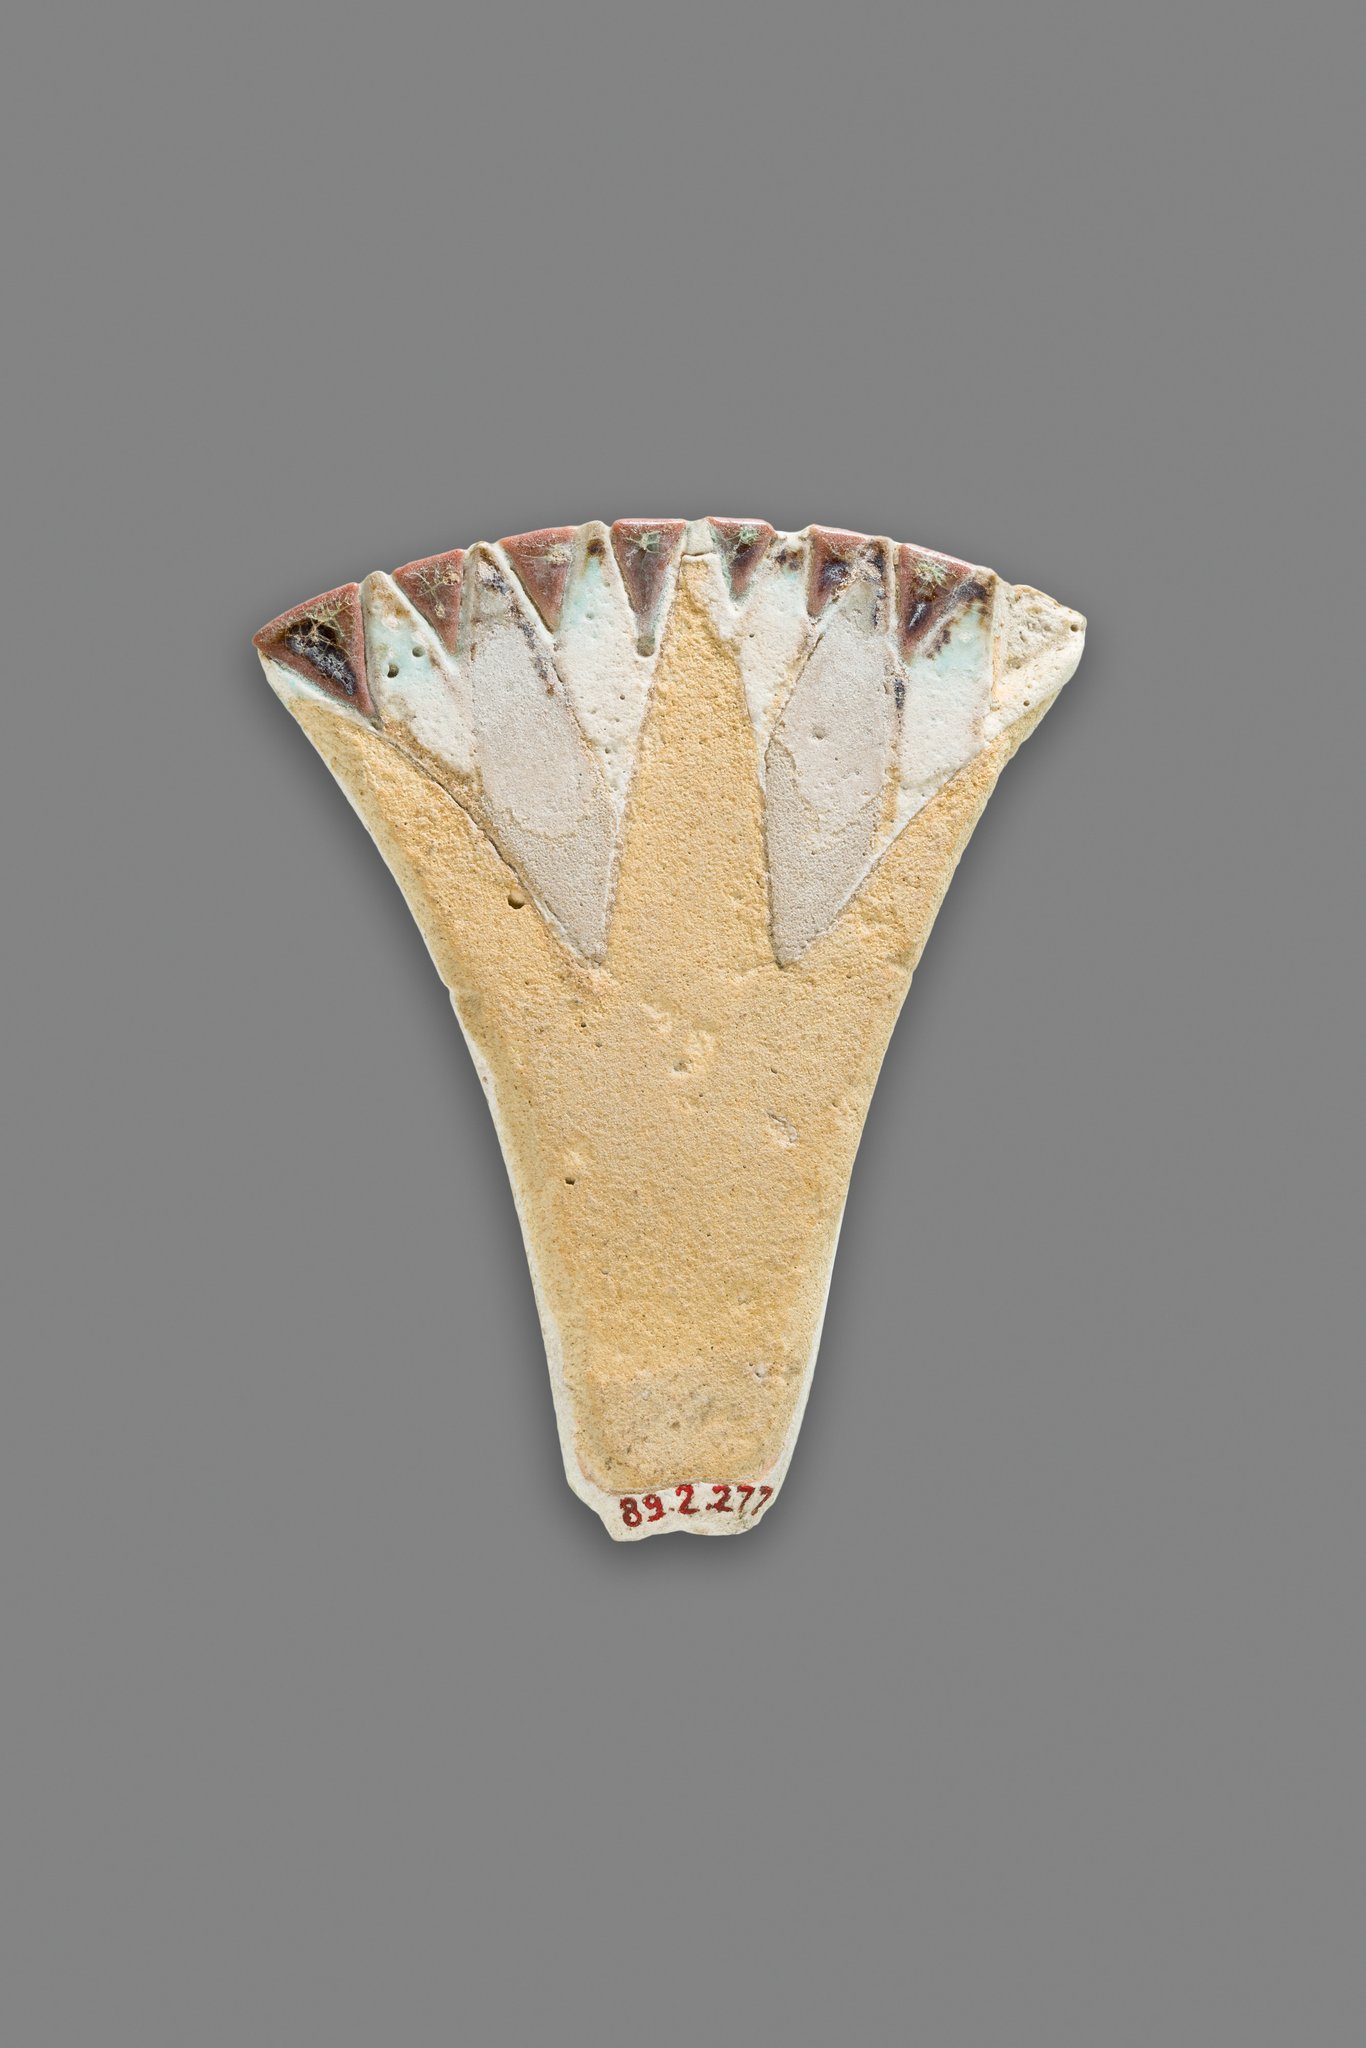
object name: inlay, lotus, lily, bud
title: Faience Inlay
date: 1184-1153 BCE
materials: faience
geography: egypt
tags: lotuses